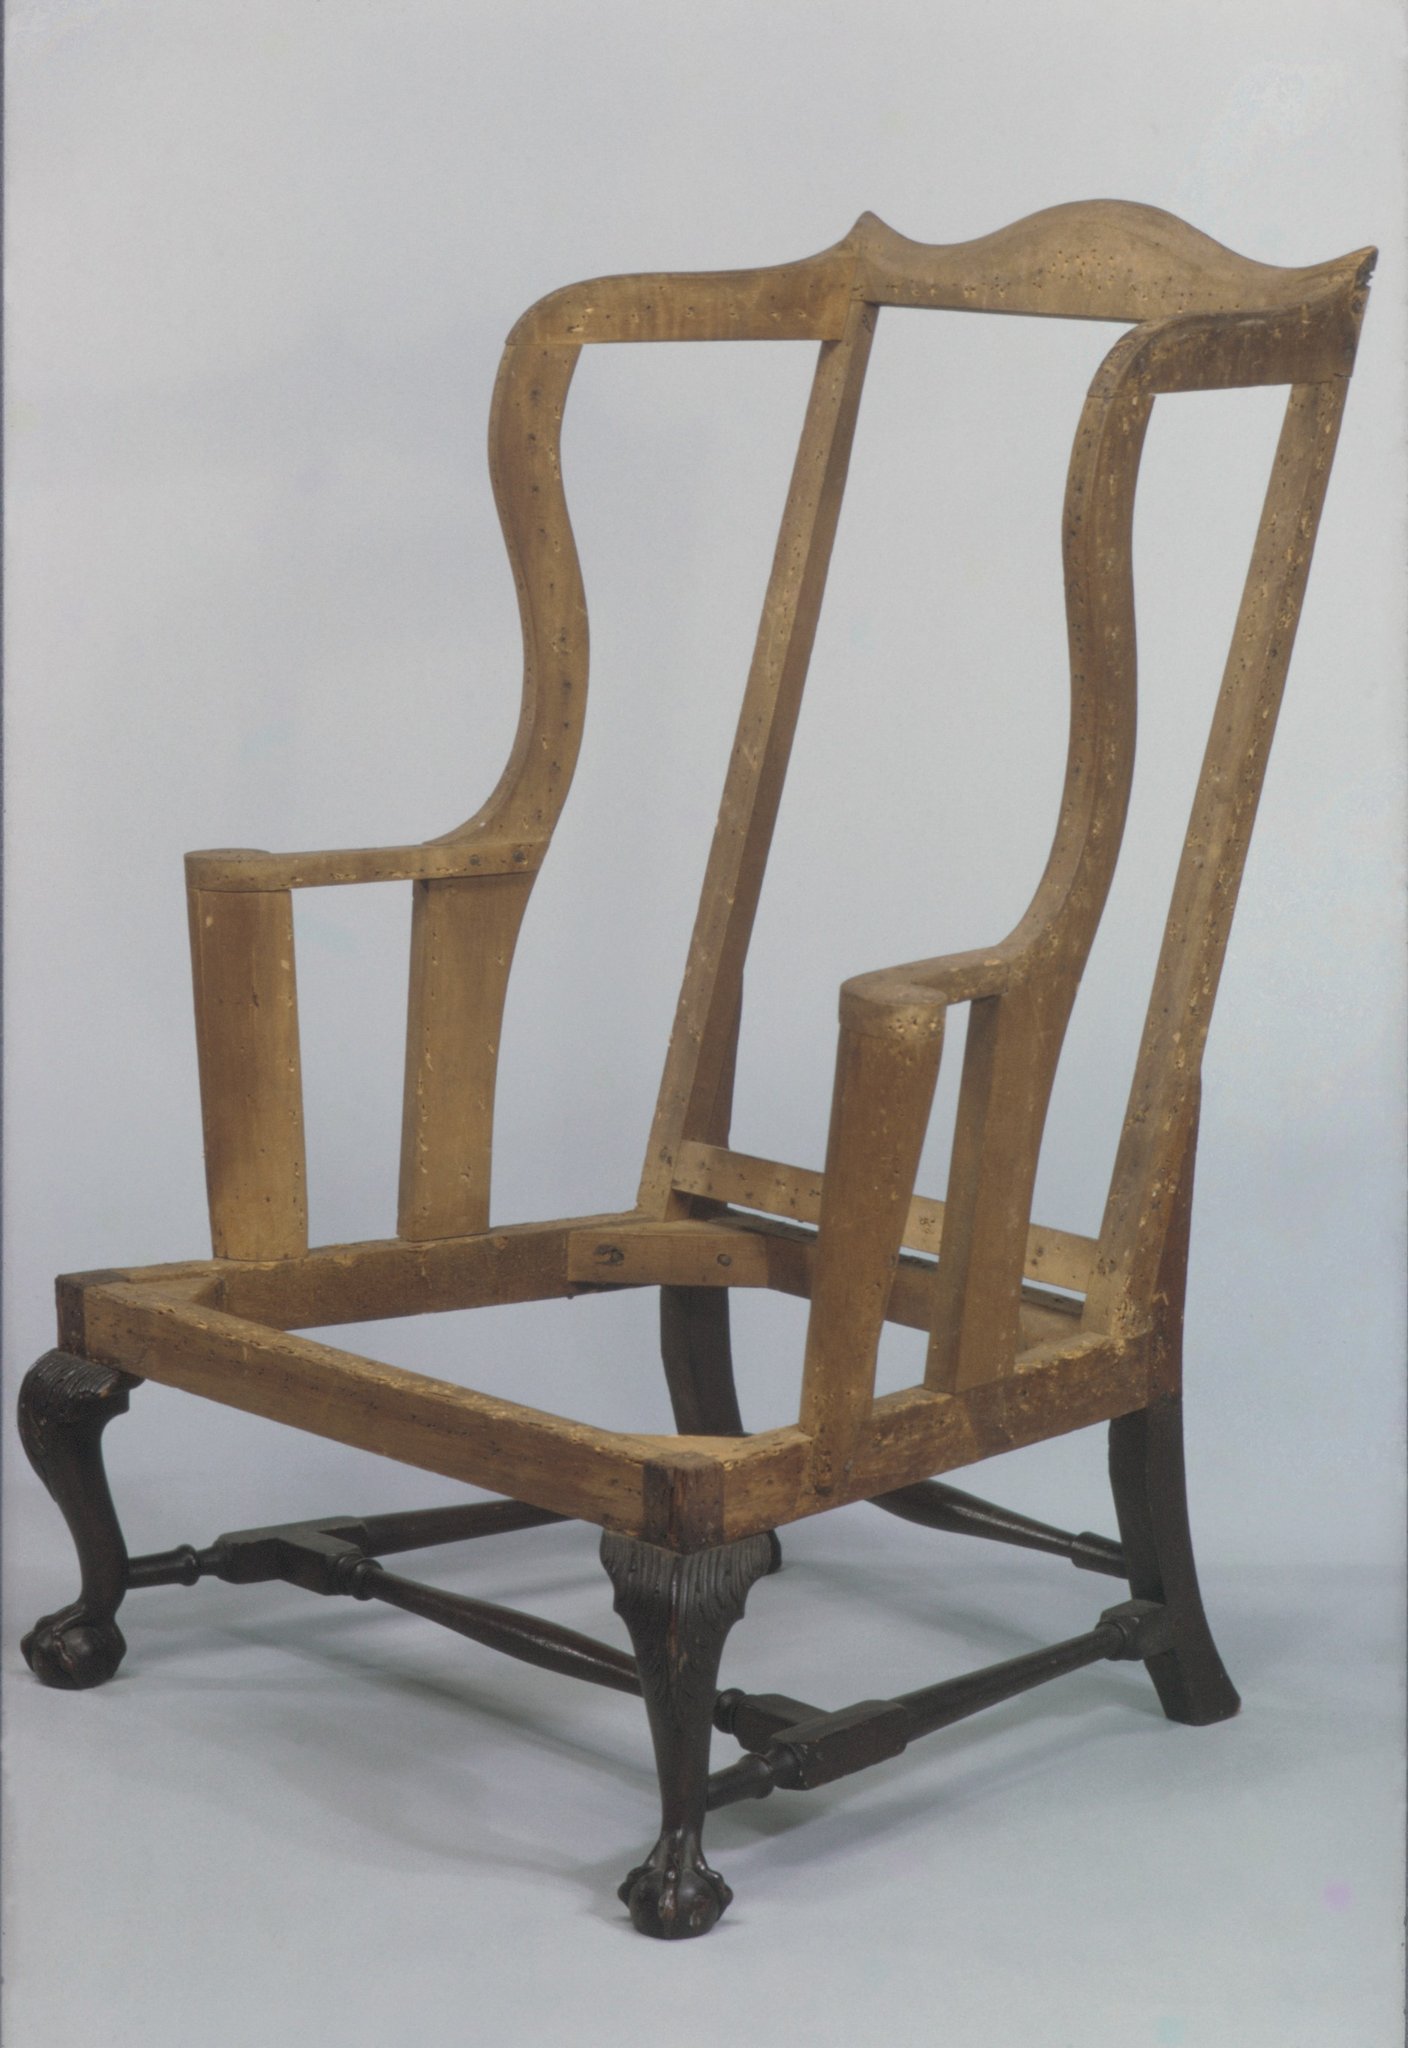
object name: easy chair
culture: american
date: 1760-1790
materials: wood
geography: united states